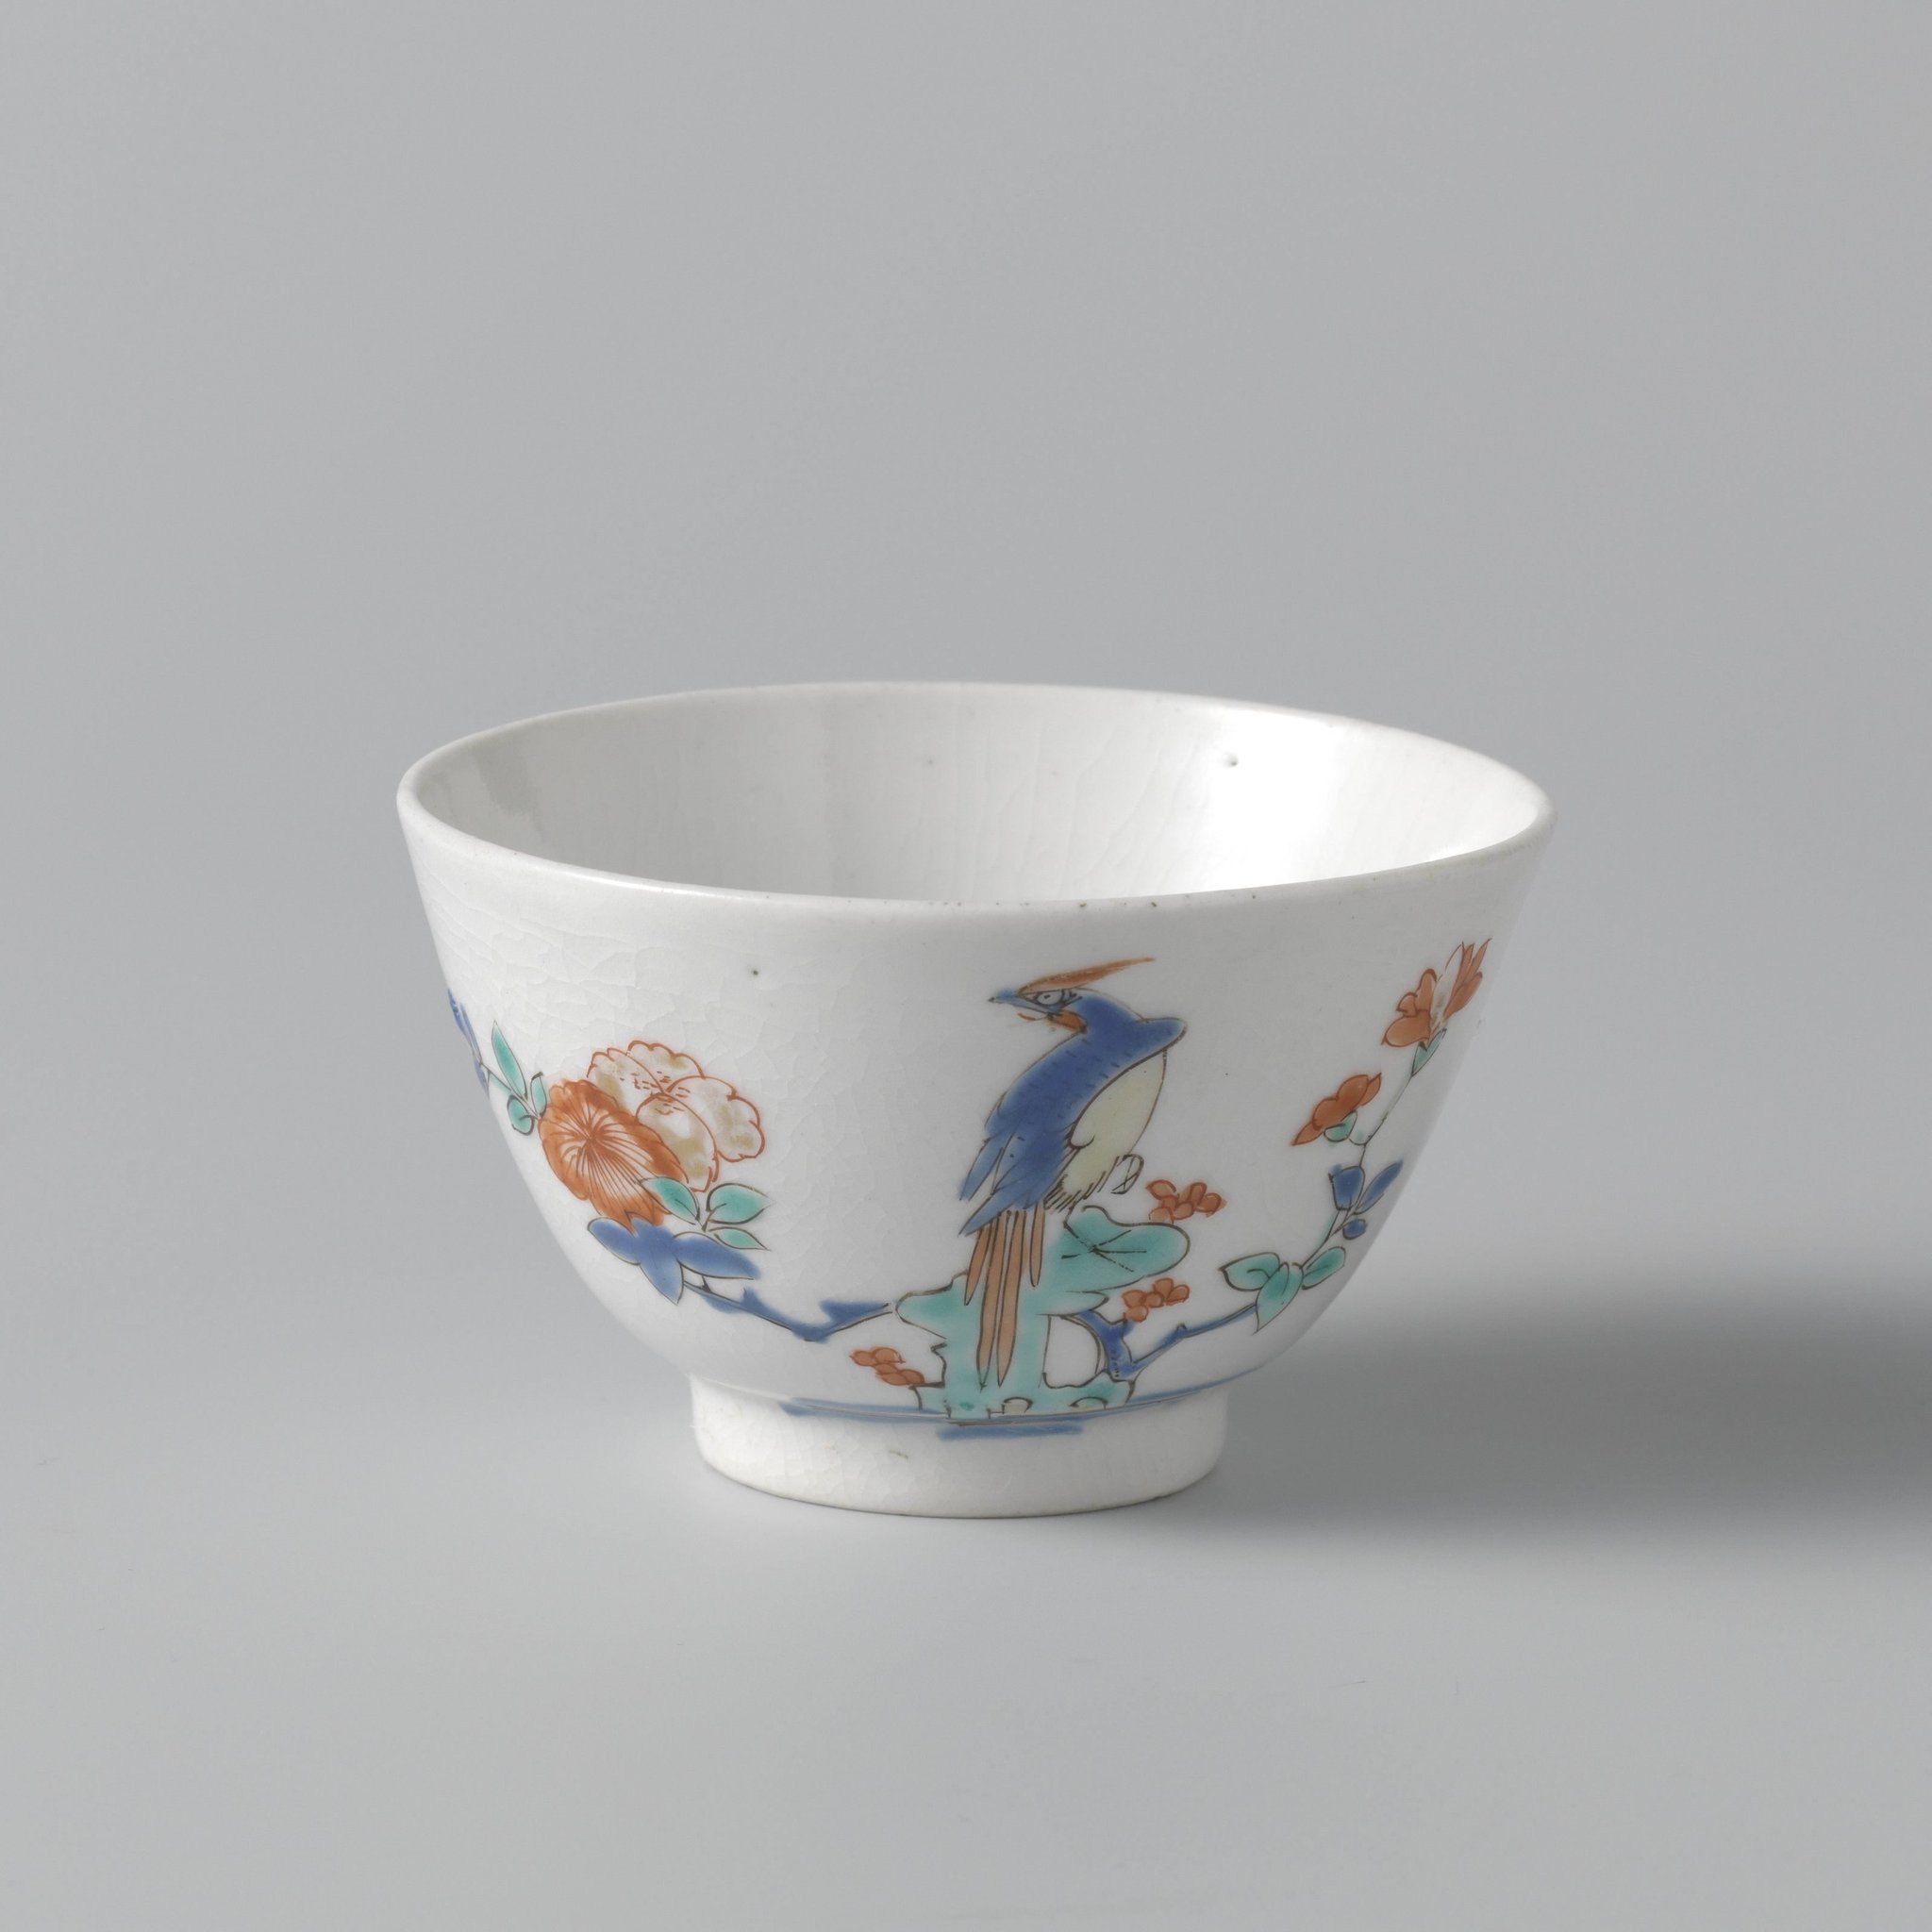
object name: cup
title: Cup with hoo birds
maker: Anonymous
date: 1670-1700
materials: glaze, gold, paint, porcelain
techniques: firing, gilding, turning, vitrification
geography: arita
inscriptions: label: ‘Collectie Westendorp/ 32’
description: Ronde kop van porselein, beschilderd op het glazuur in blauw, rood, groen, geel, zwart en goud met een een paar hoo-vogels, een in de lucht en een op een rots met een bloemtak. Binnen op de bodem een rozet binnen een dubbele cirkel in rood en goud. Oud label op de onderzijde met 'Collectie Westendorp/ 32'. Kakiemon-stijl.